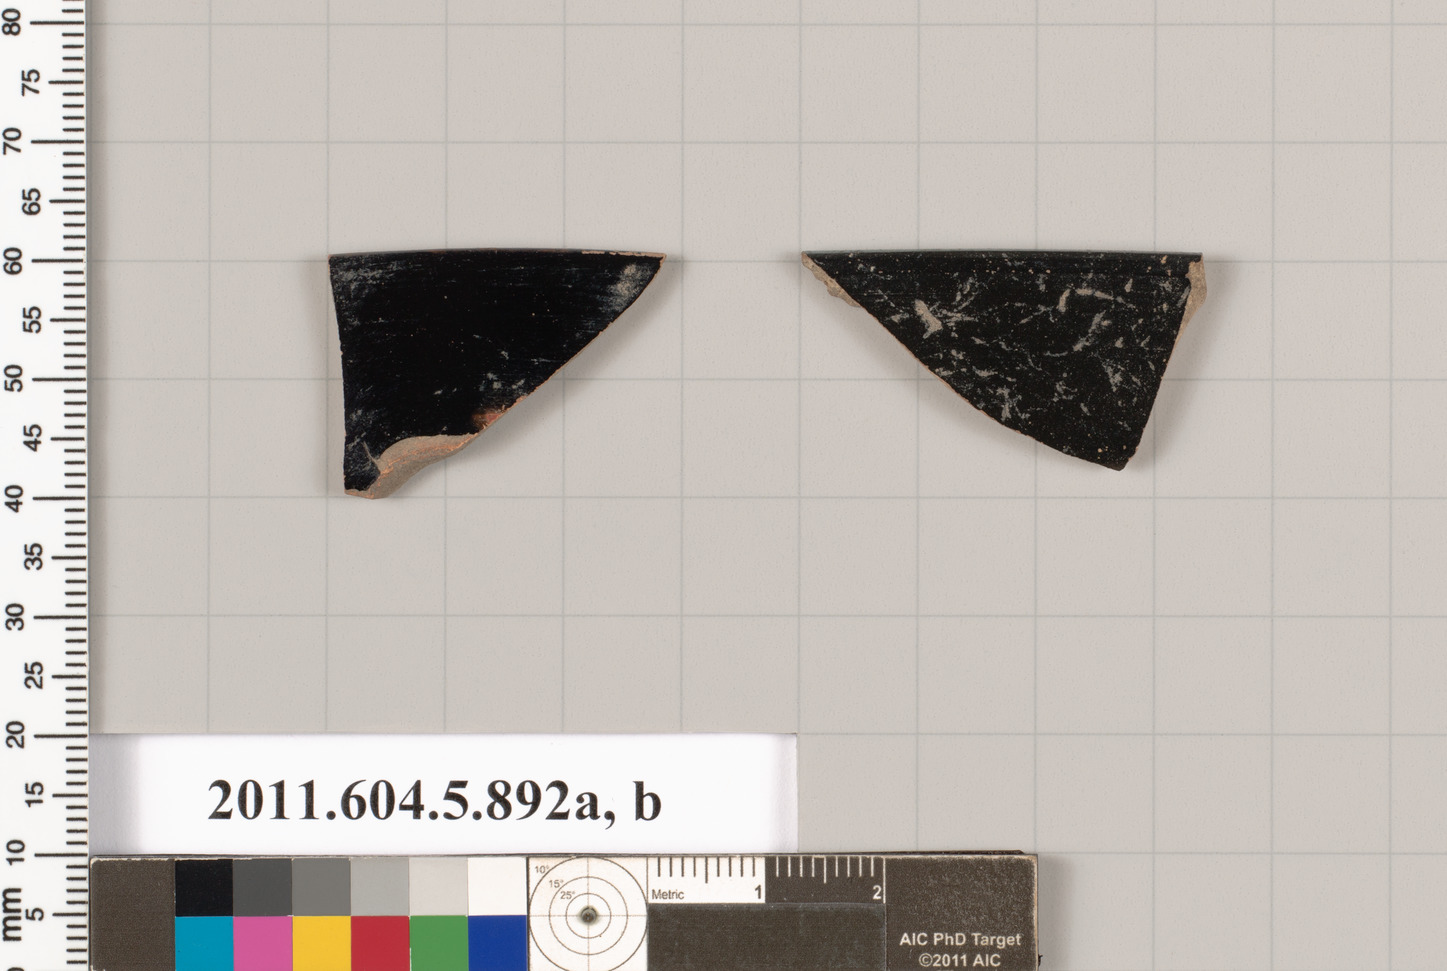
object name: kylix fragment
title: Terracotta rim fragments of kylikes (drinking cups)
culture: greek, attic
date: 600-401 BCE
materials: terracotta